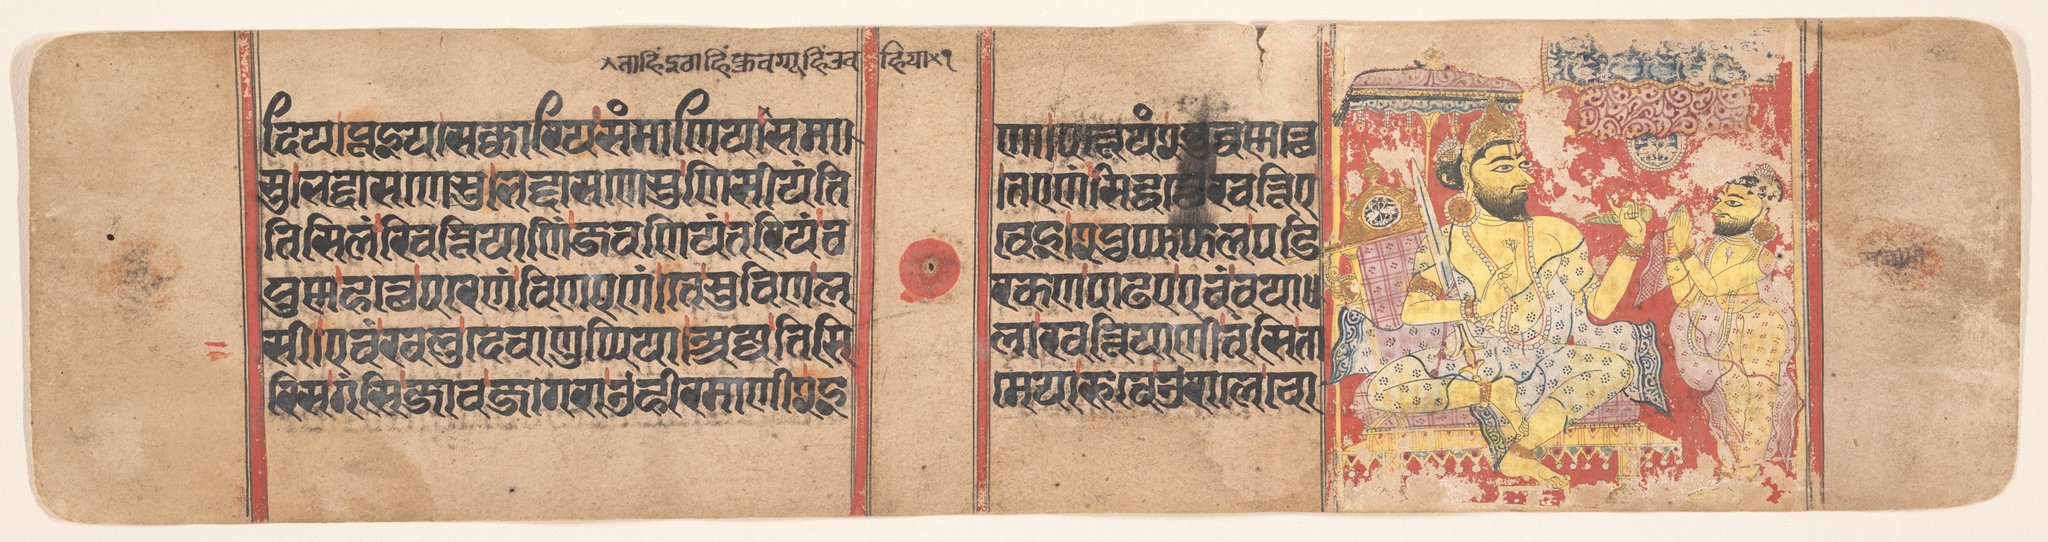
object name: folio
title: King Siddharta Listens to an Astrologer Forecast the Conception and Birth of His Son, the Jina Mahavira: Folio from a Kalpasutra Manuscript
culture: indian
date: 1367-1400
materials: paper, watercolor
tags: kings,men